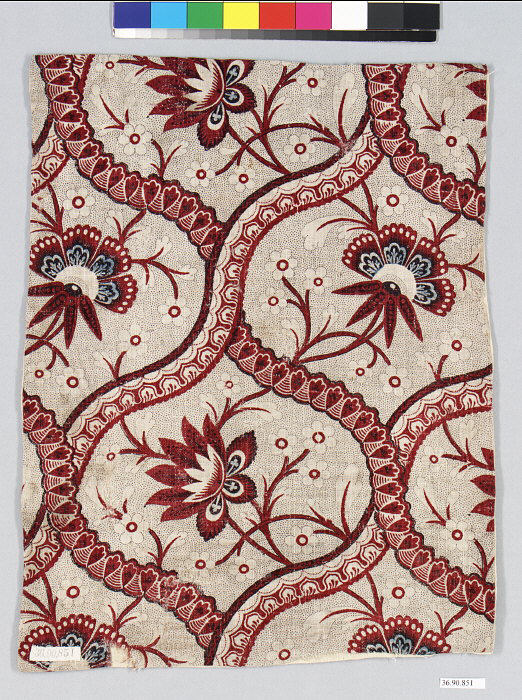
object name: piece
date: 1701-1800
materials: cotton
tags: flowers